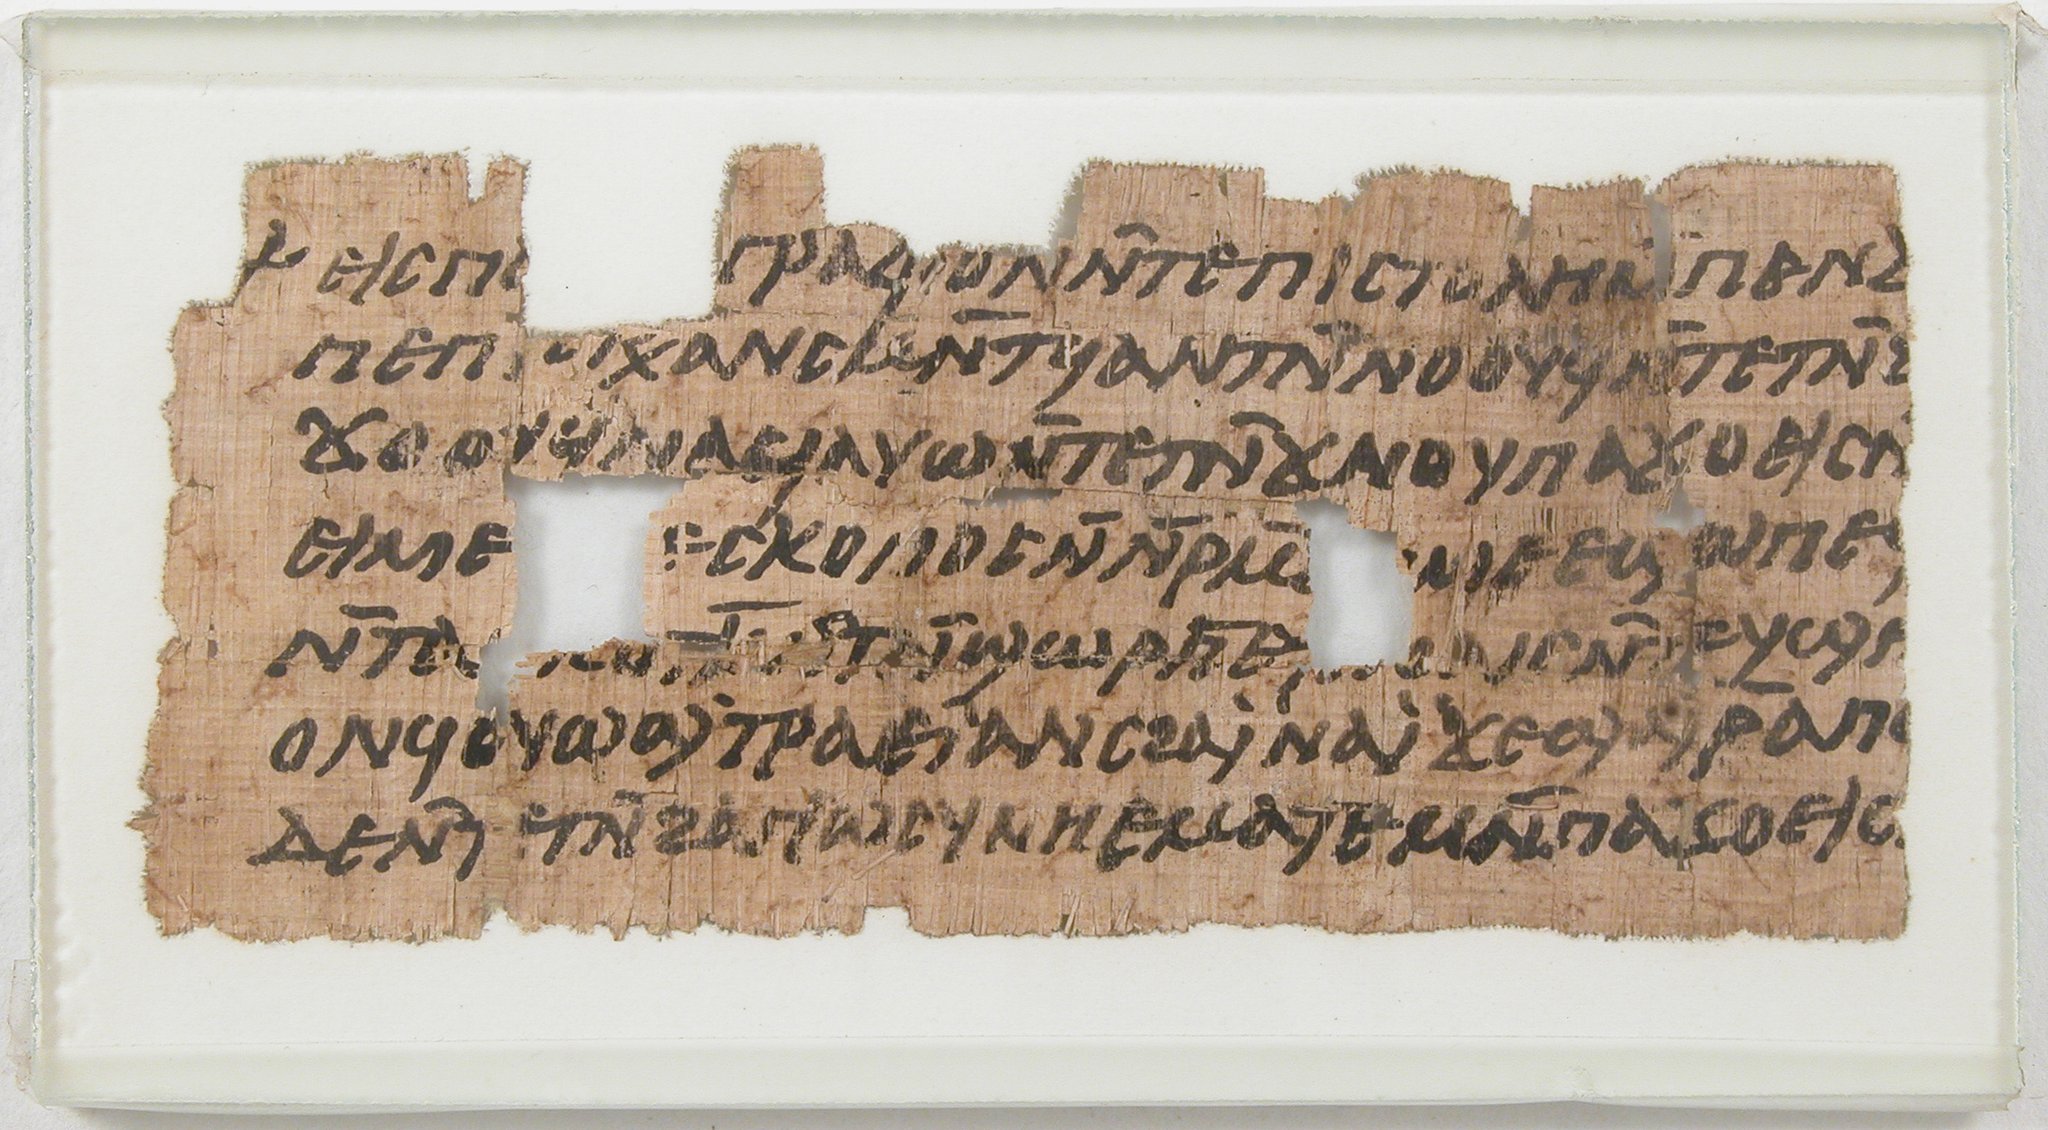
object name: fragment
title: Papyrus Fragment of a Letter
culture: coptic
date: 580-640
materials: ink, papyrus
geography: egypt